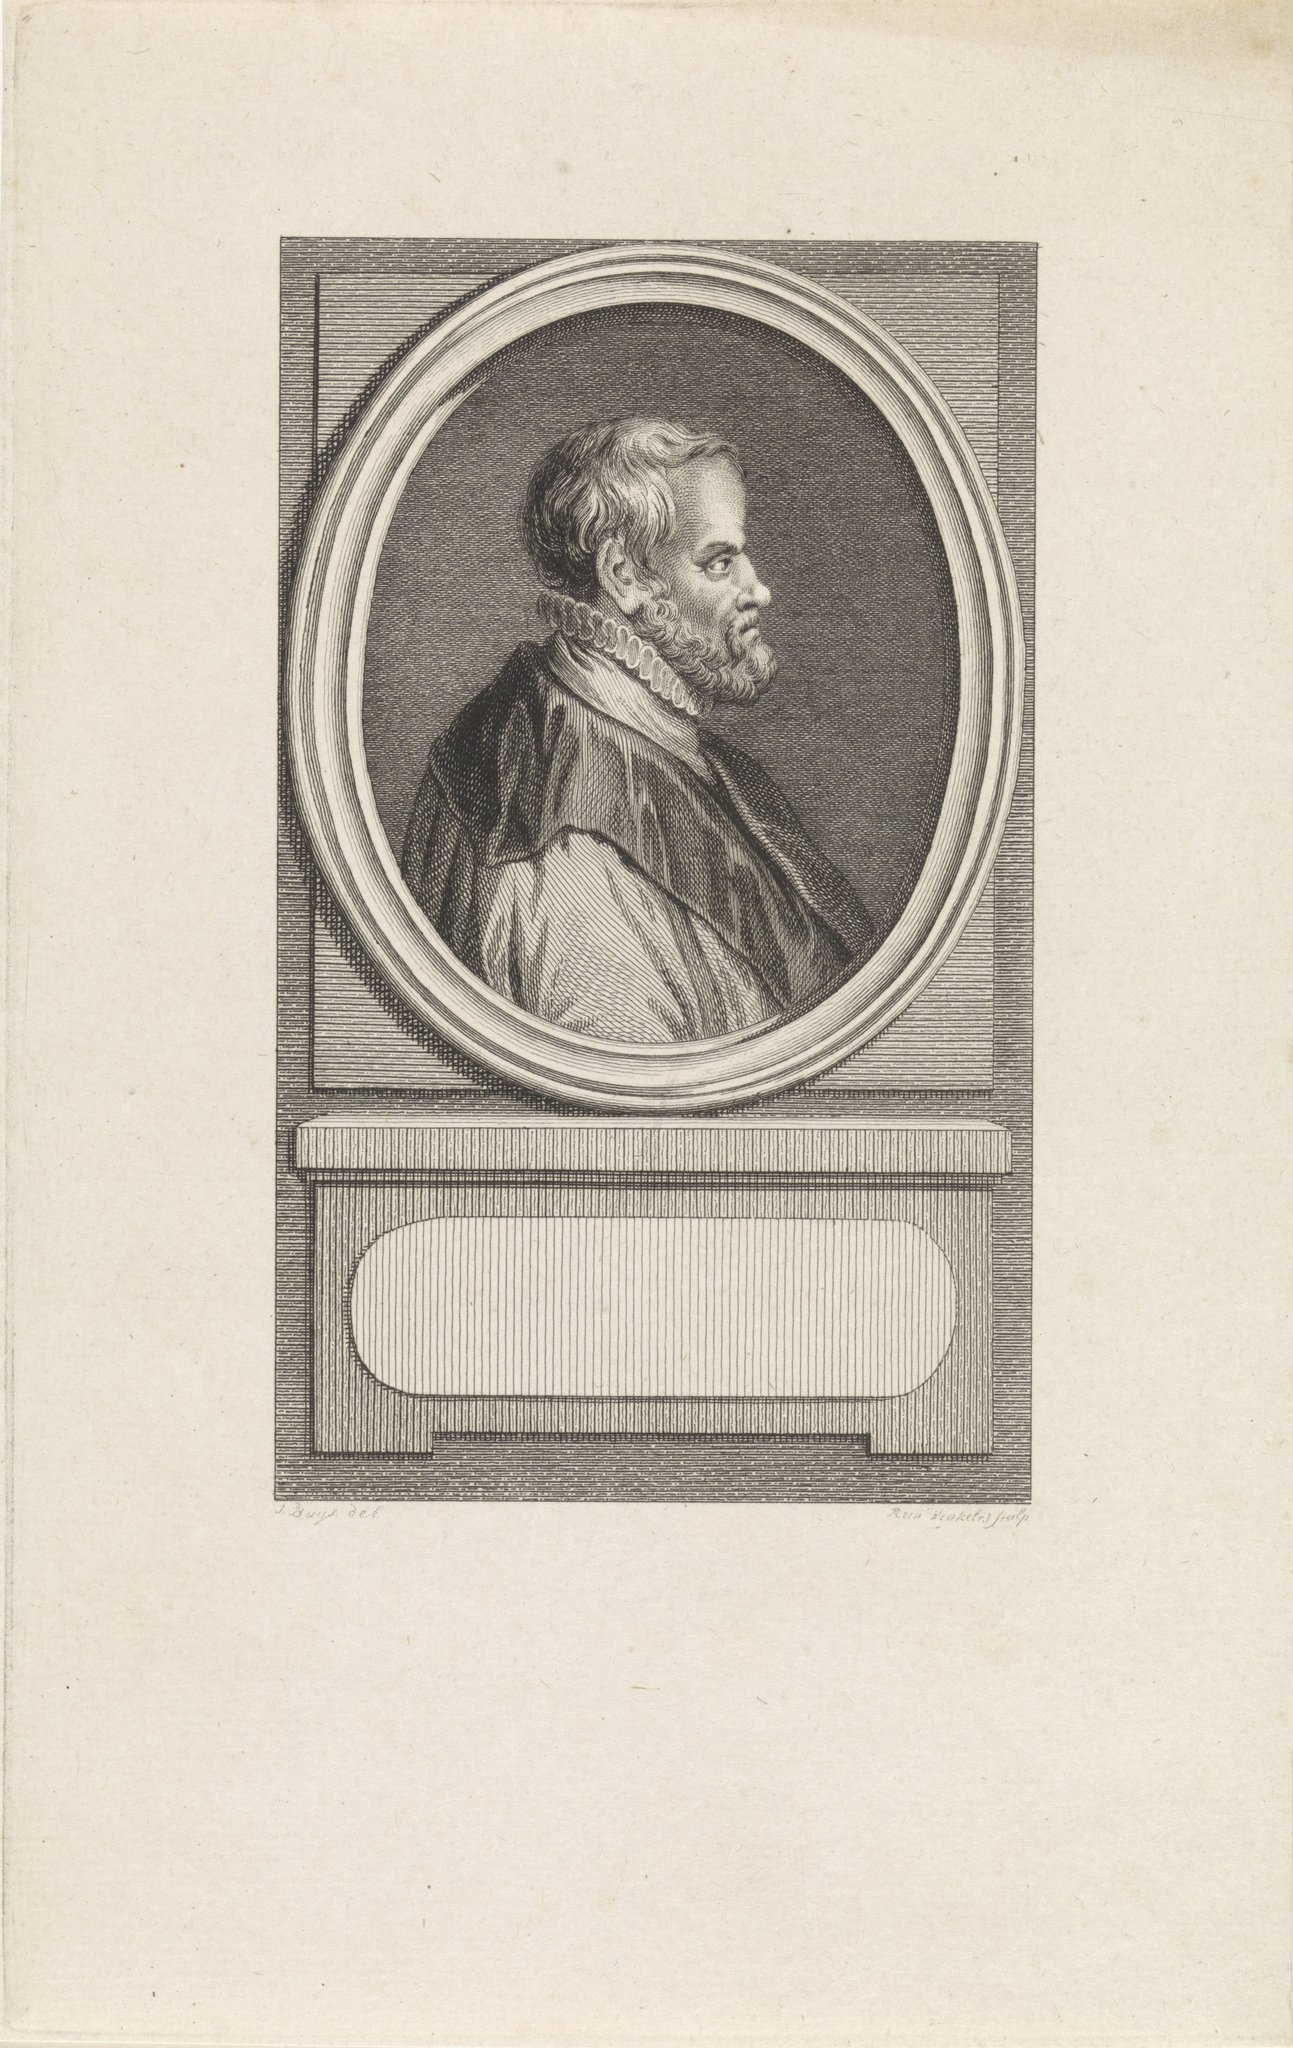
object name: print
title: Portret van Christoffel de Assonville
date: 1786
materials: paper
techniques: engraving, etching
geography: amsterdam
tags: brussels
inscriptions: collector's mark: Lugt 2228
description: Latere staat prent gebruikt als boekillustratie in: Kok, Jacobus. Vaderlandsch woordenboek : met kaarten, plaaten en pourtraitten. Amsterdam: Johannes Allart, 1785-1796. Deel IV.